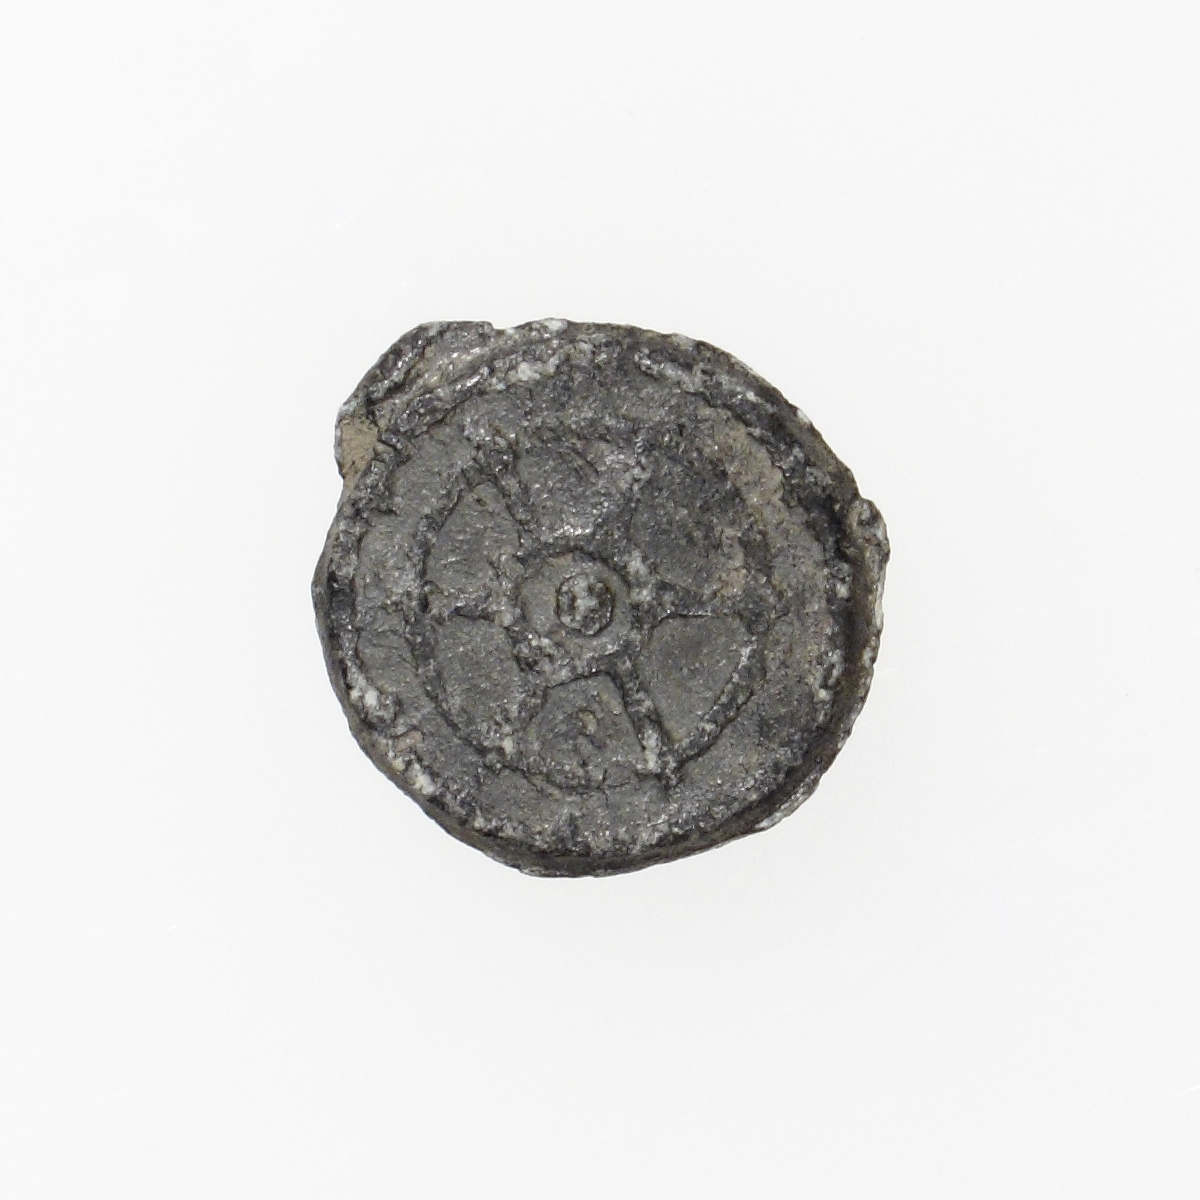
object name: pilgrim's badge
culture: french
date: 1301-1600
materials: lead